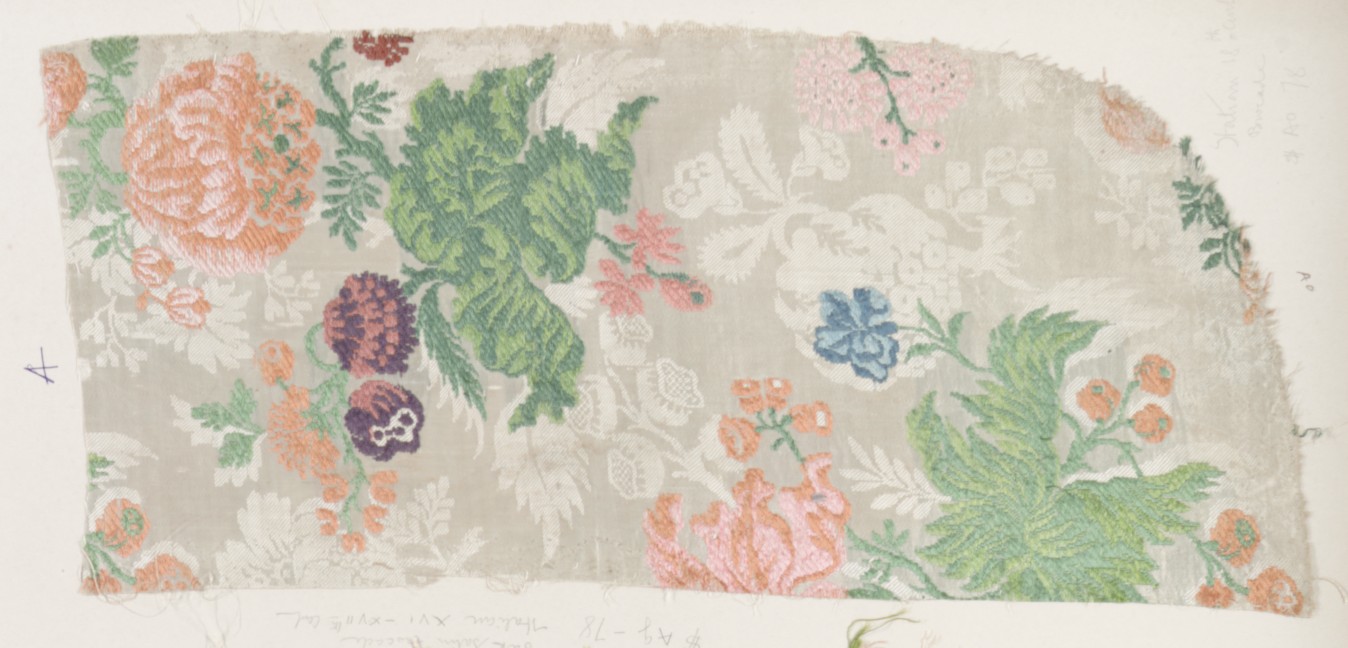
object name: fragment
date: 1701-1800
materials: silk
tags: flowers,leaves